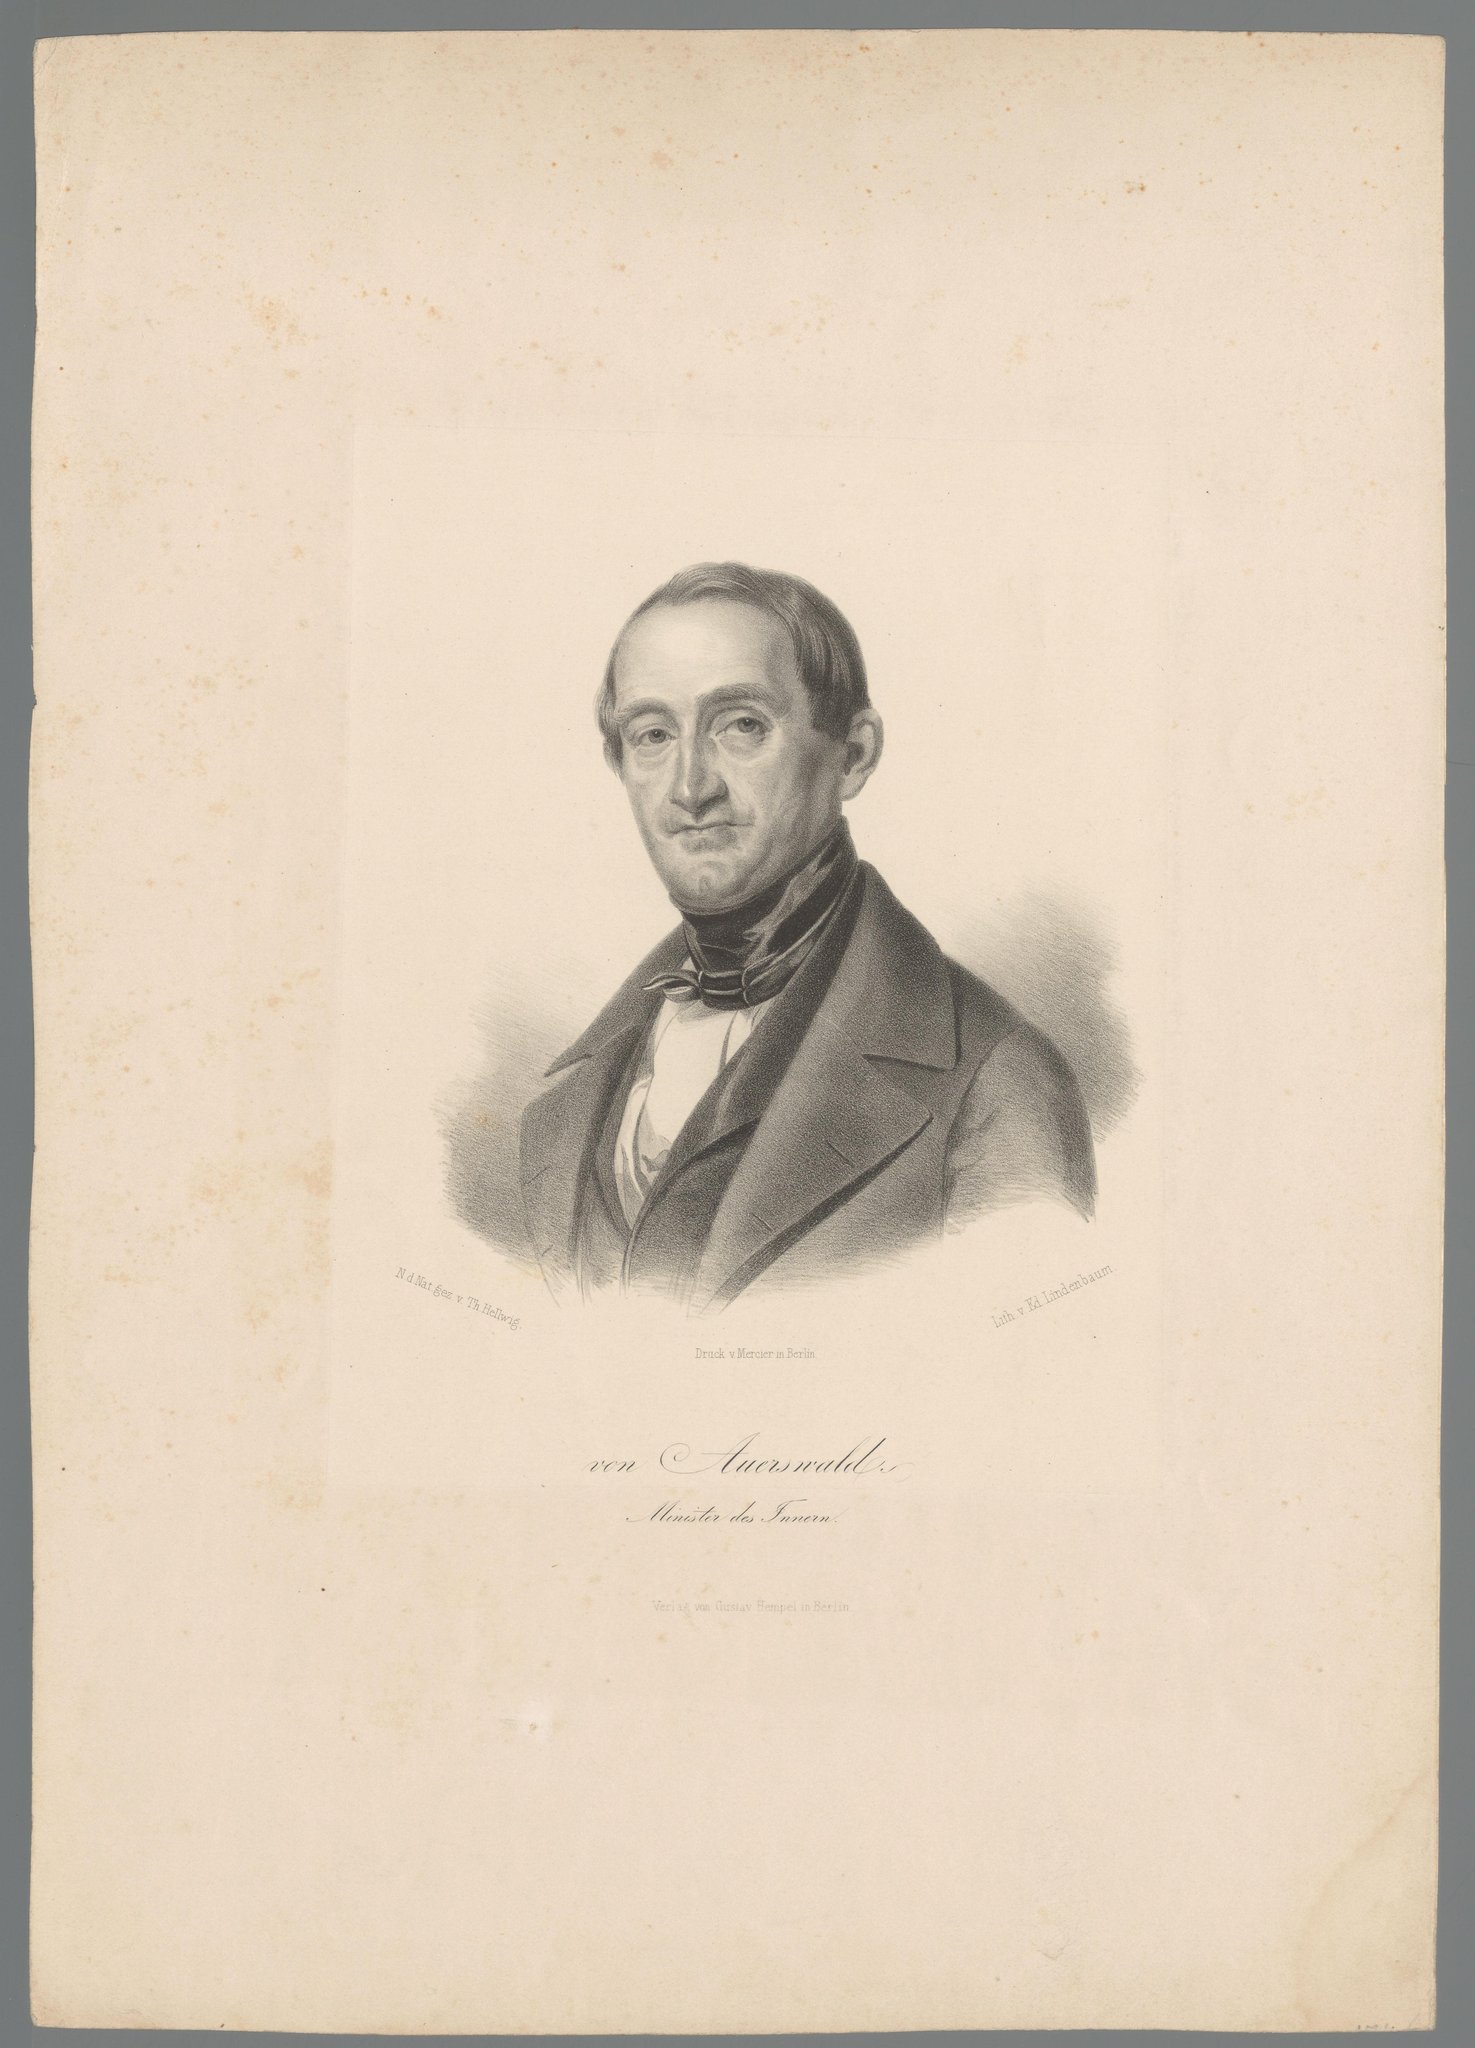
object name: print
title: Von Auerswald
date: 1846-1877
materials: paper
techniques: lithograph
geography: berlin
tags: historical persons, politician, e.g. party leader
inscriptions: collector's mark: Lugt 2228